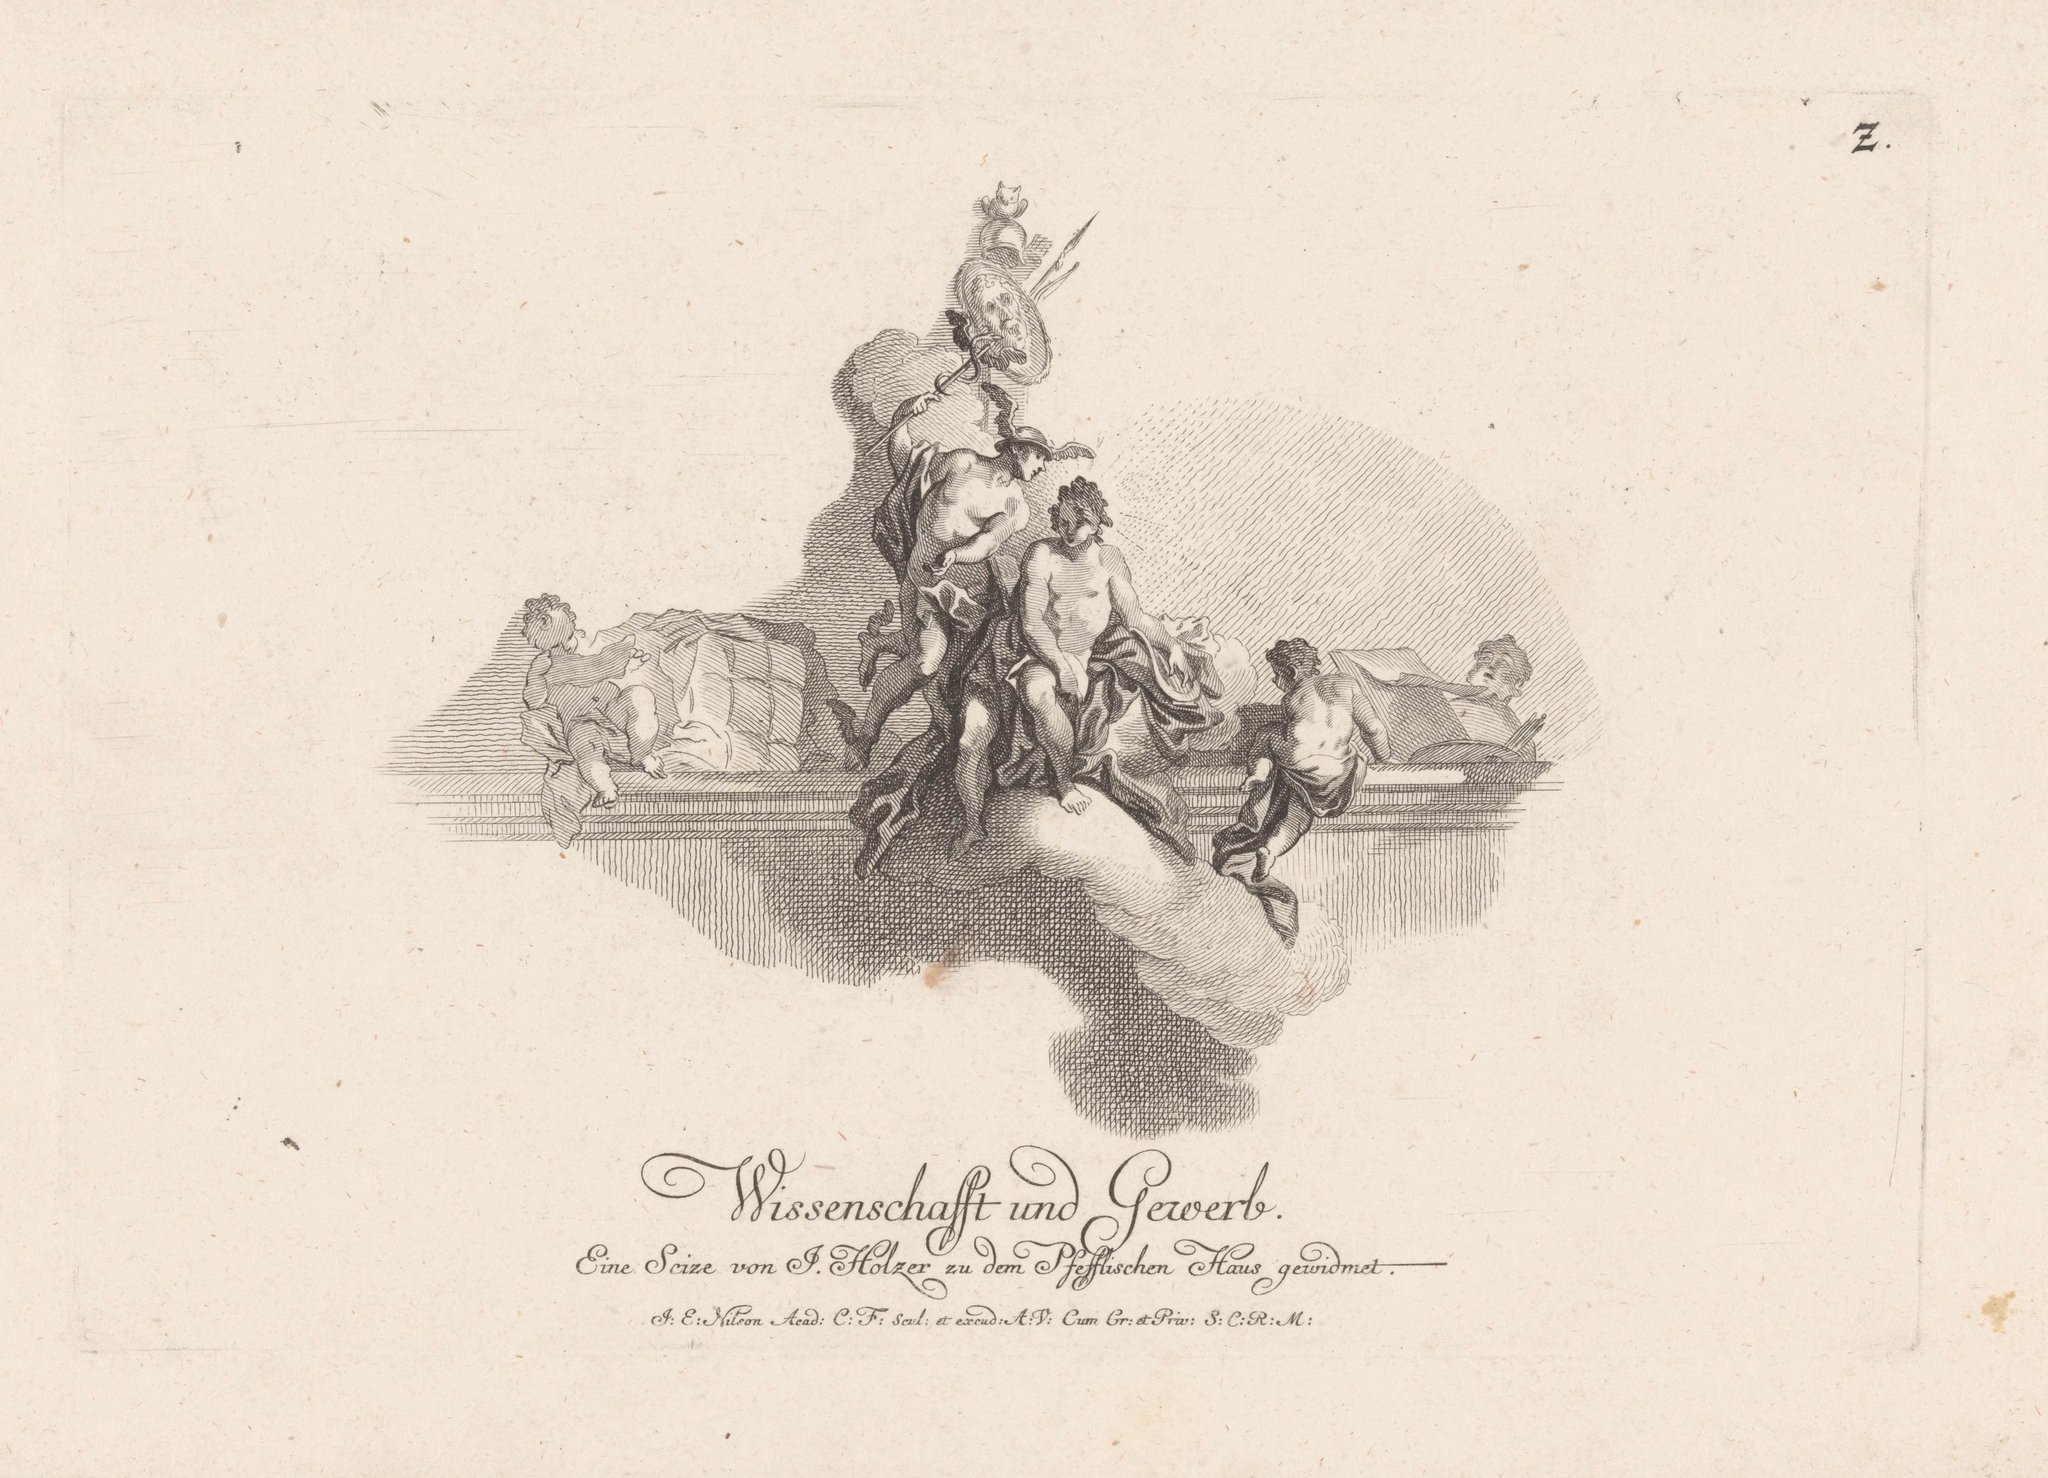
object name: print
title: Picturae a Fresco in Aedibus Augustae Vindelic (...)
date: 1765-1770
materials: paper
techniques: engraving, etching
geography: augsburg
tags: attributes of minerva, specific aspects, allegorical aspects of mercury; mercury as patron, specific aspects, allegorical aspects of apollo; apollo as patron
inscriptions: collector's mark: Lugt 2760, collector's mark: Lugt 2228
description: Mercurius en Apollo symboliseren de handel en de kunsten. Boven hen wordt Minerva, de godin van de wijsheid, door een helm, uil en schild met Medusa-kop gesymboliseerd. Aan beide zijden spelen putti naast symbolen voor de handel, kunsten en wetenschappen.